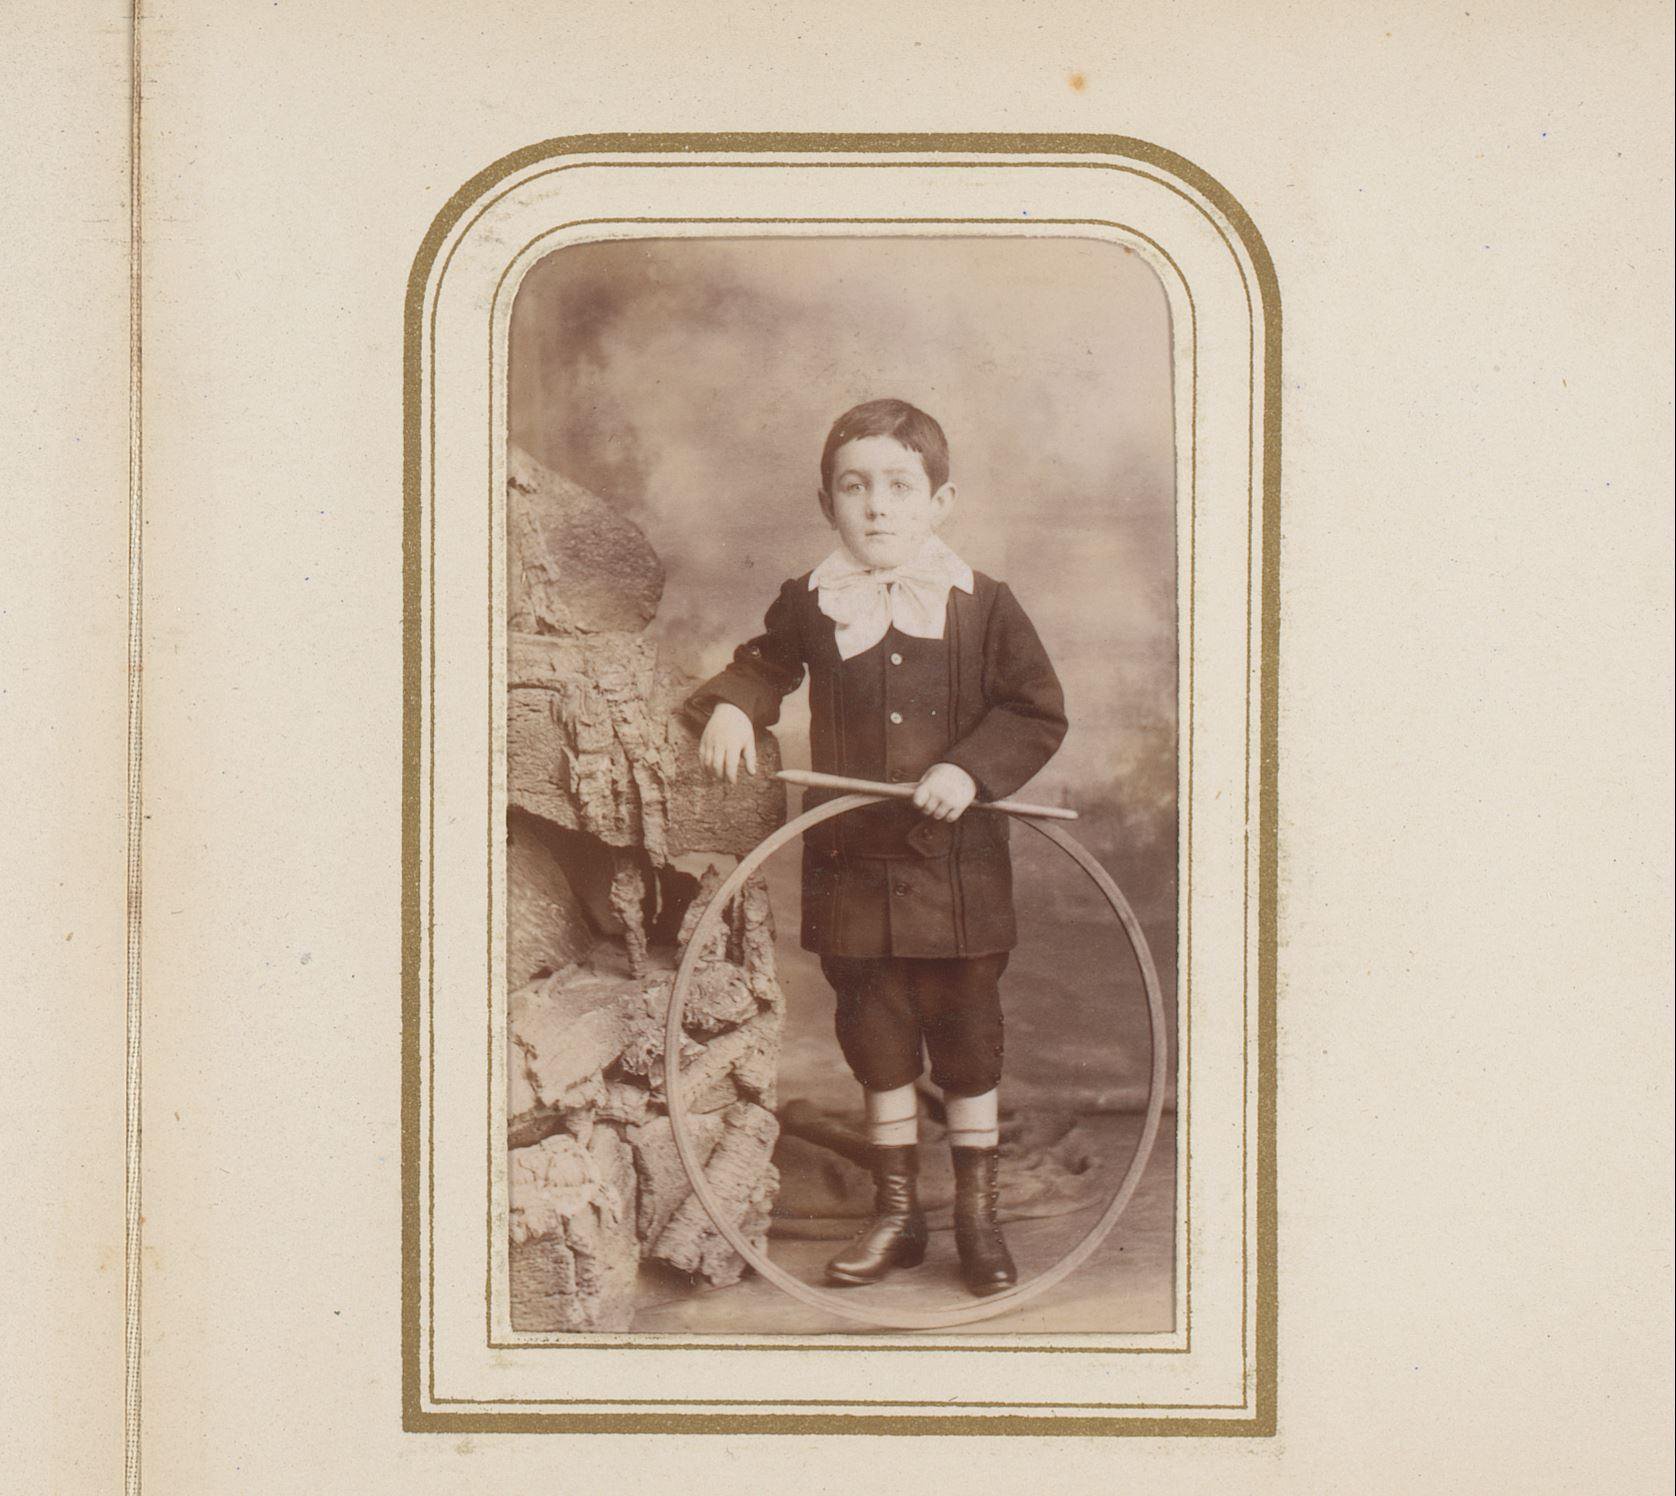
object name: album leaf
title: Portret van een jongen met hoepel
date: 1860-1900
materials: cardboard, photographic support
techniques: albumen print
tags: boy (child between toddler and youth), historical persons, (bowling a) hoop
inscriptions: inscription: ‘Phototgraphie/ de l'Hotel de Ville/ L. Muller-Rault/ 48Bis/ Rue de Rivoli/ Paris/ (...)’